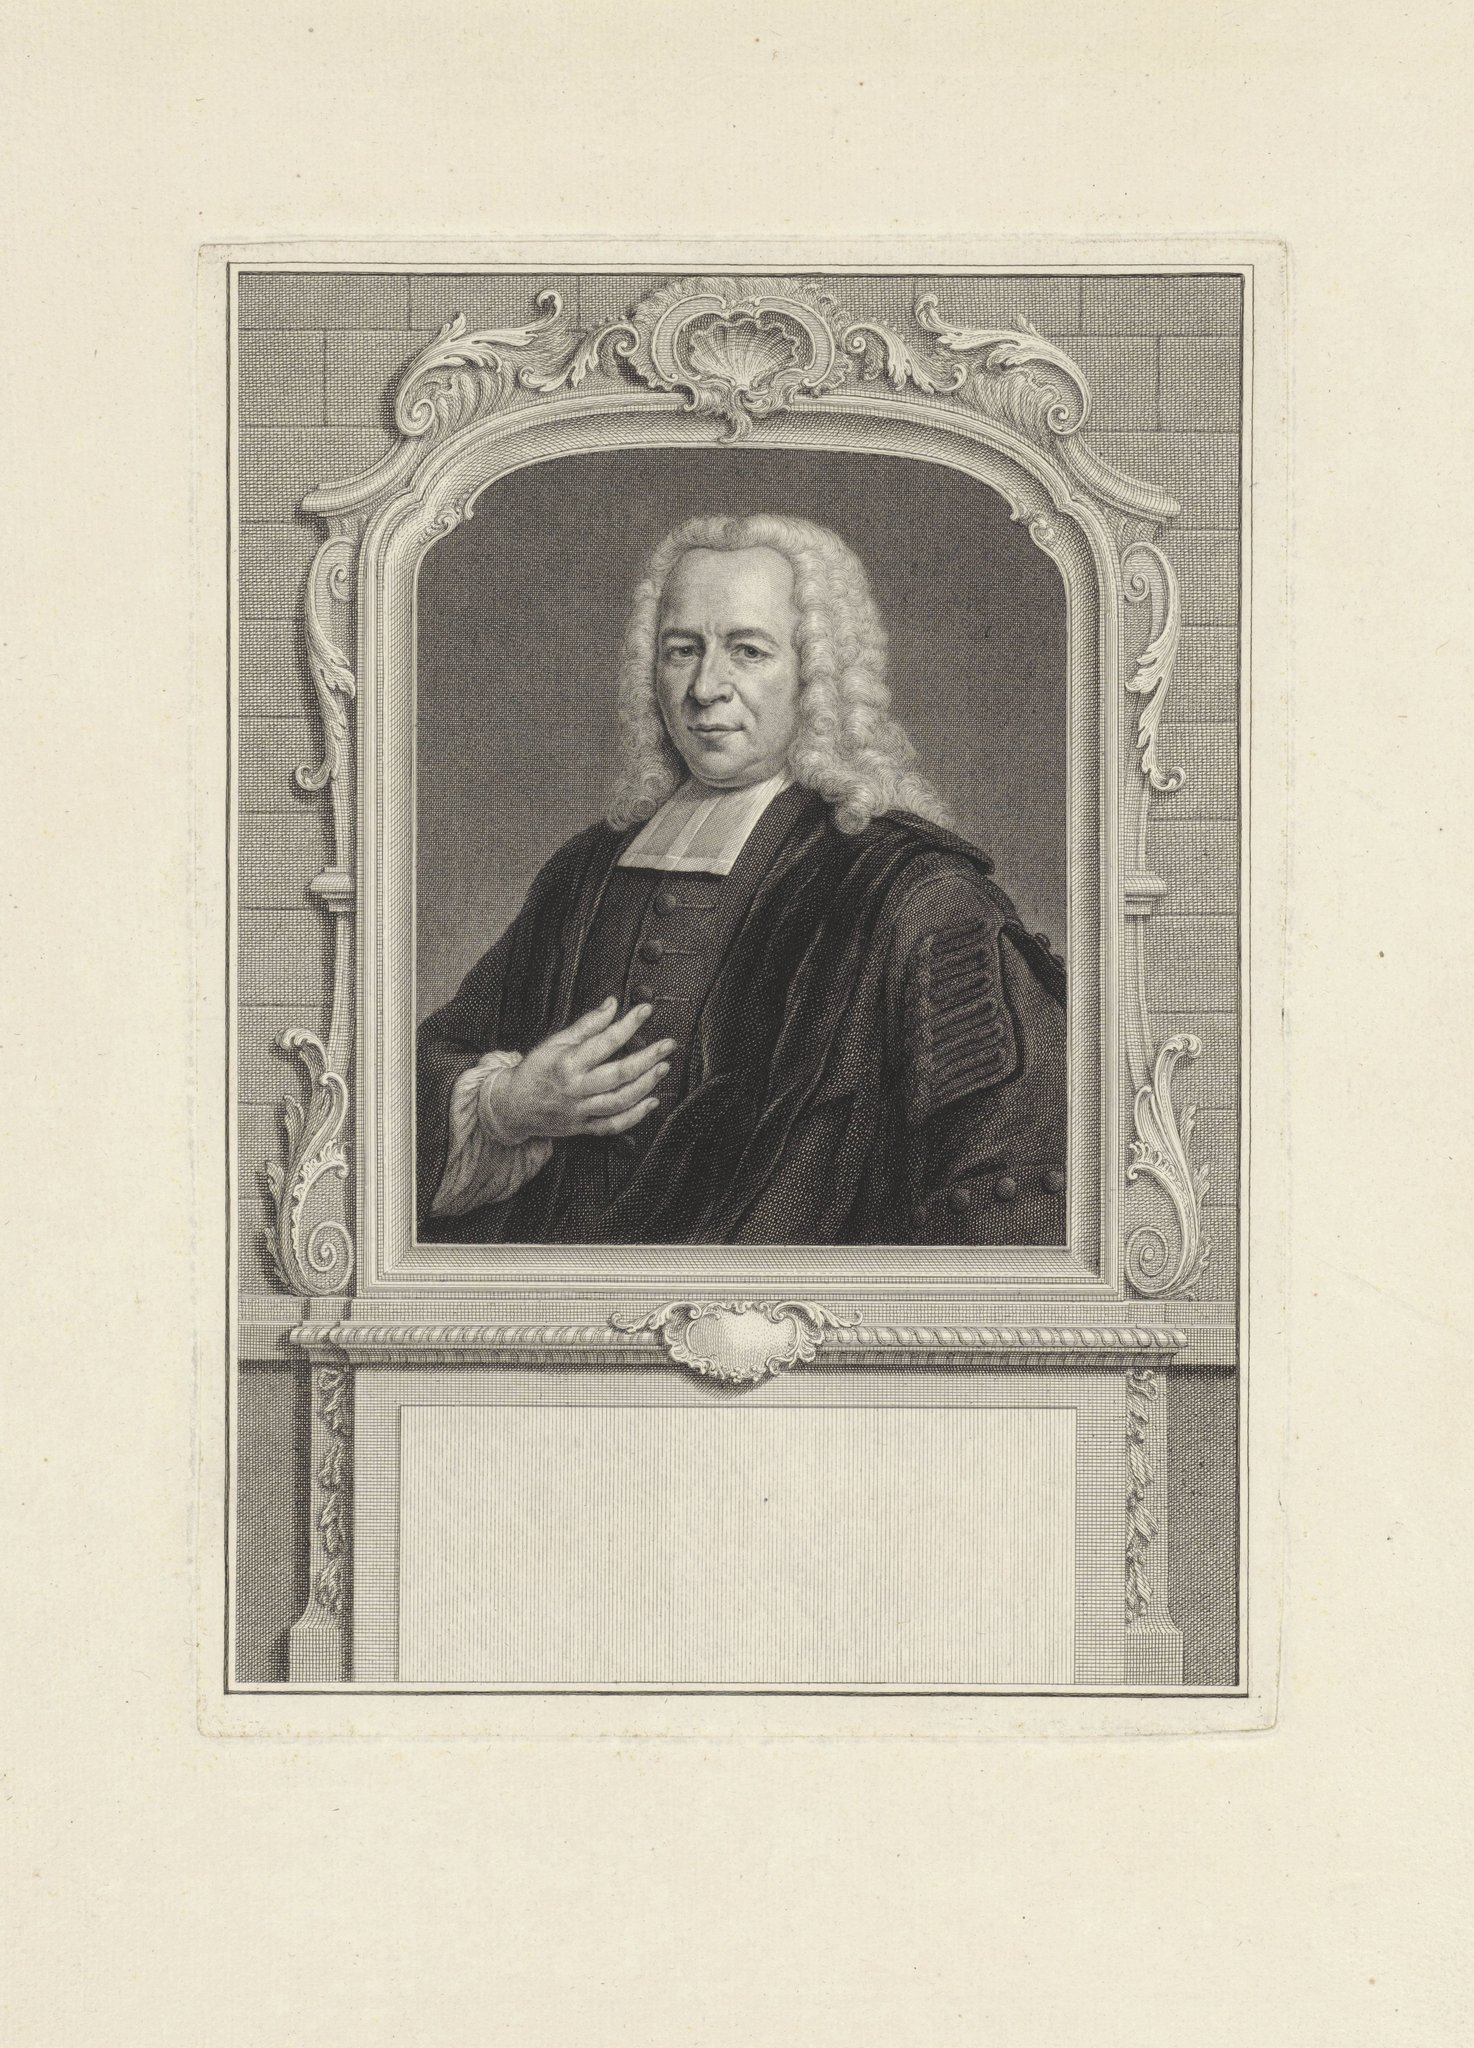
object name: print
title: Portret van Willem van Irhoven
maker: pieter tanjé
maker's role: draughtsman, print maker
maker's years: 1706-1761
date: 1716-1761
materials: paper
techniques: engraving, etching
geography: amsterdam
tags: utrecht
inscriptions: collector's mark: Lugt 240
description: Portret van Willem van Irhoven, gereformeerd predikant te Ede en hoogleraar in de theologie en kerkgeschiedenis te Utrecht.